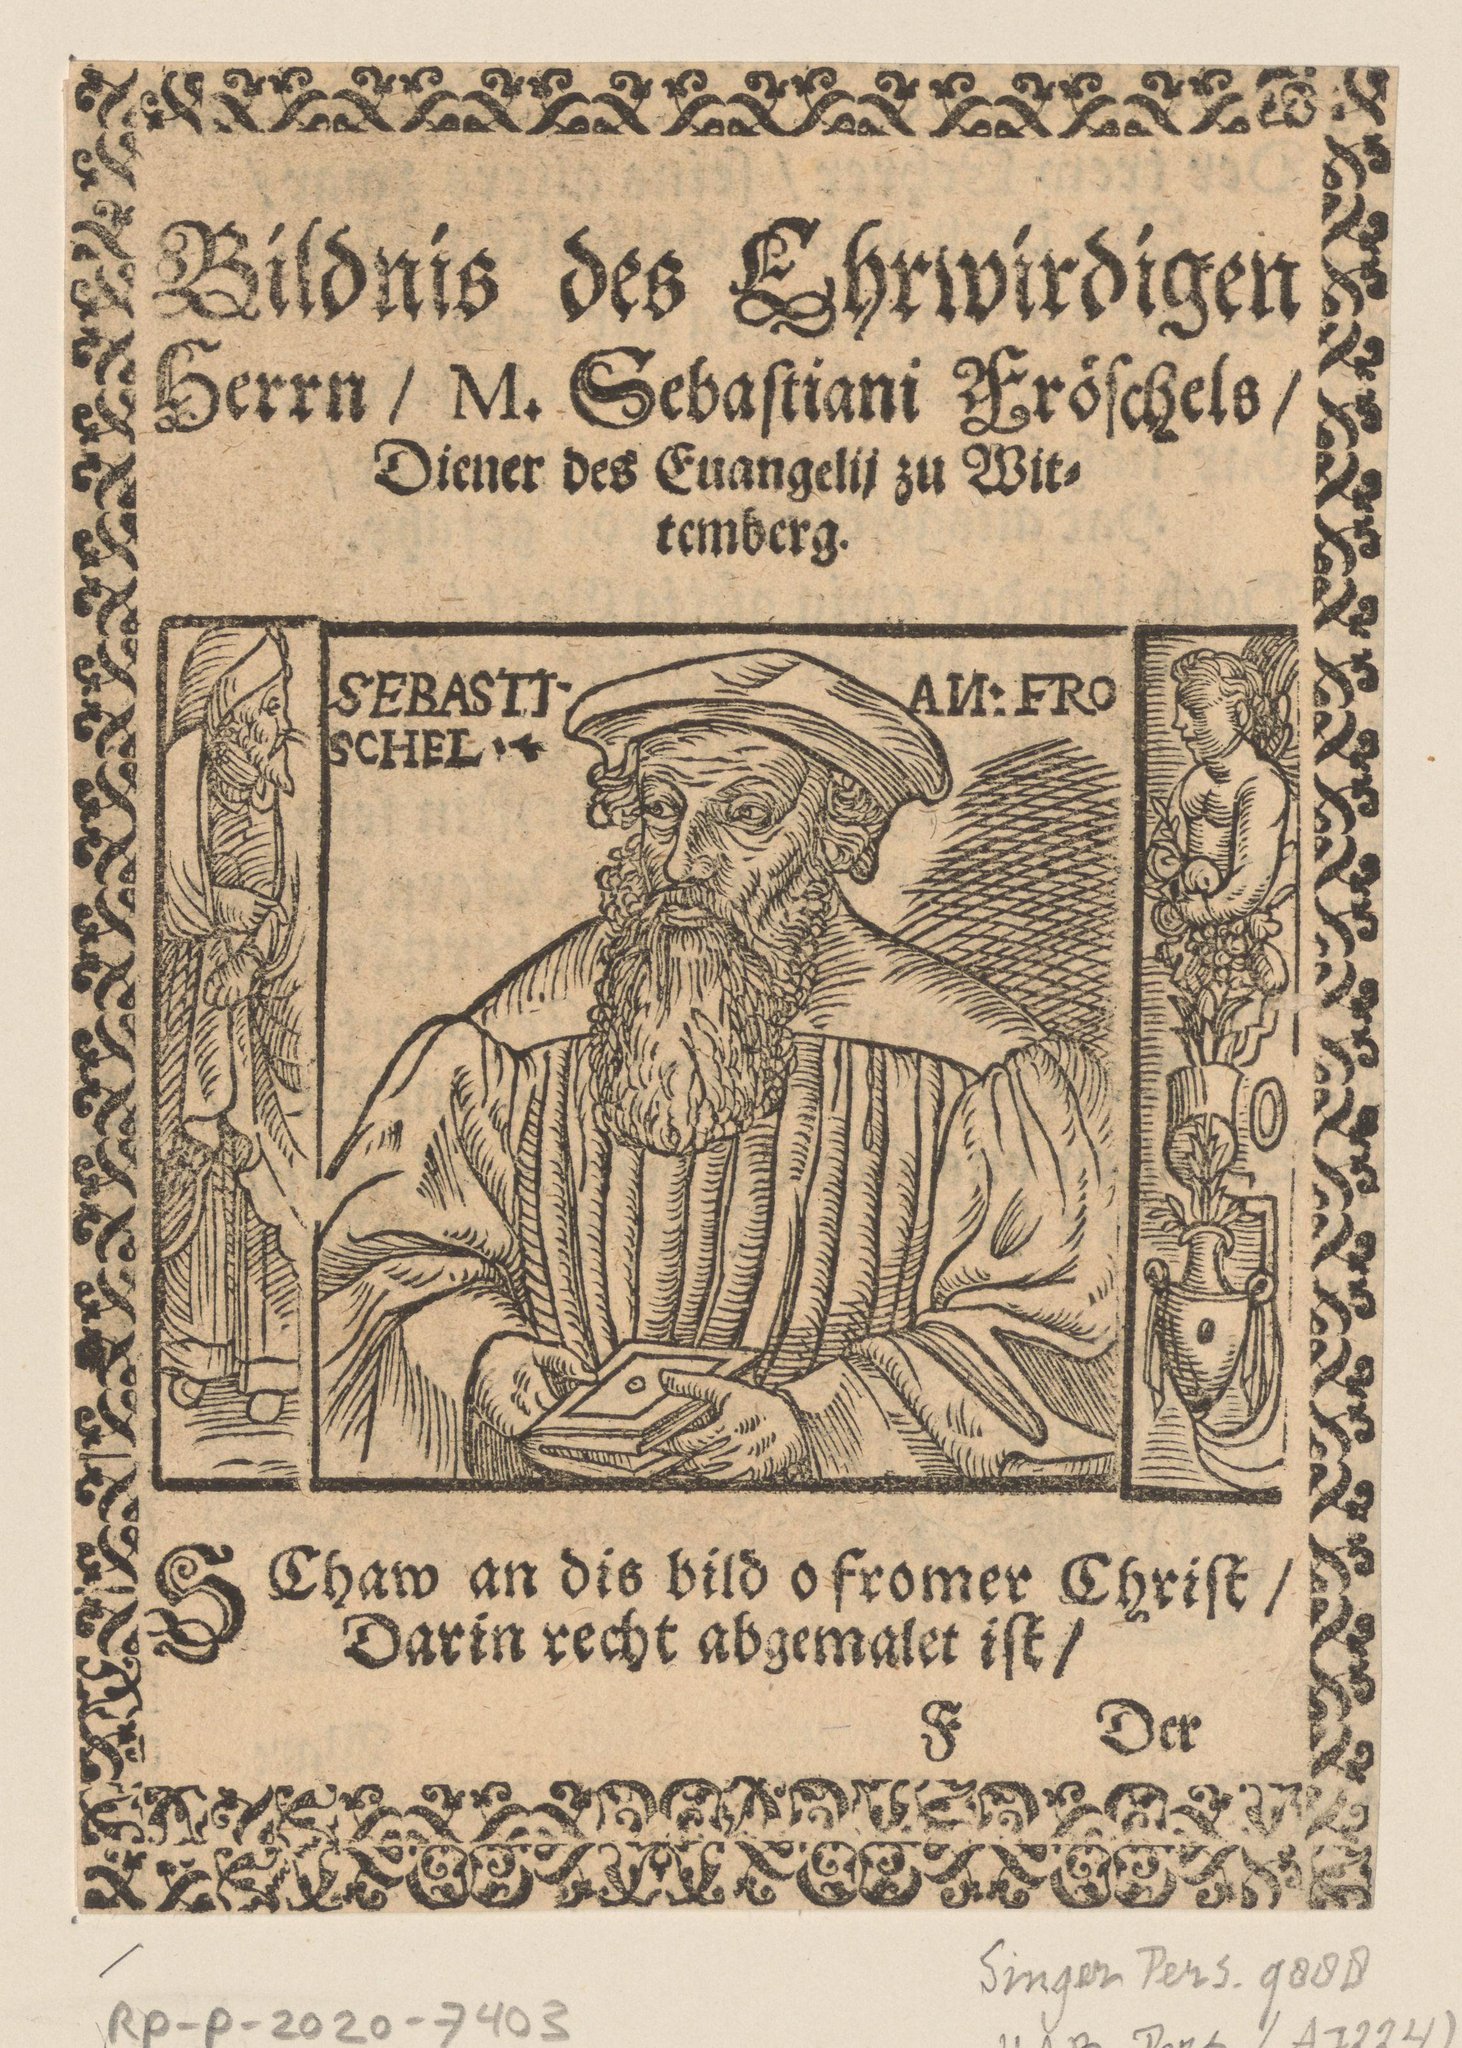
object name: book illustration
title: Portret van Sebastian Fröschel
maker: Anonymous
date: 1530-1599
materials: paper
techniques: letterpress printing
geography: germany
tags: amberg, theologian, historical persons, book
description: Portret komt uit een onbekende publicatie.